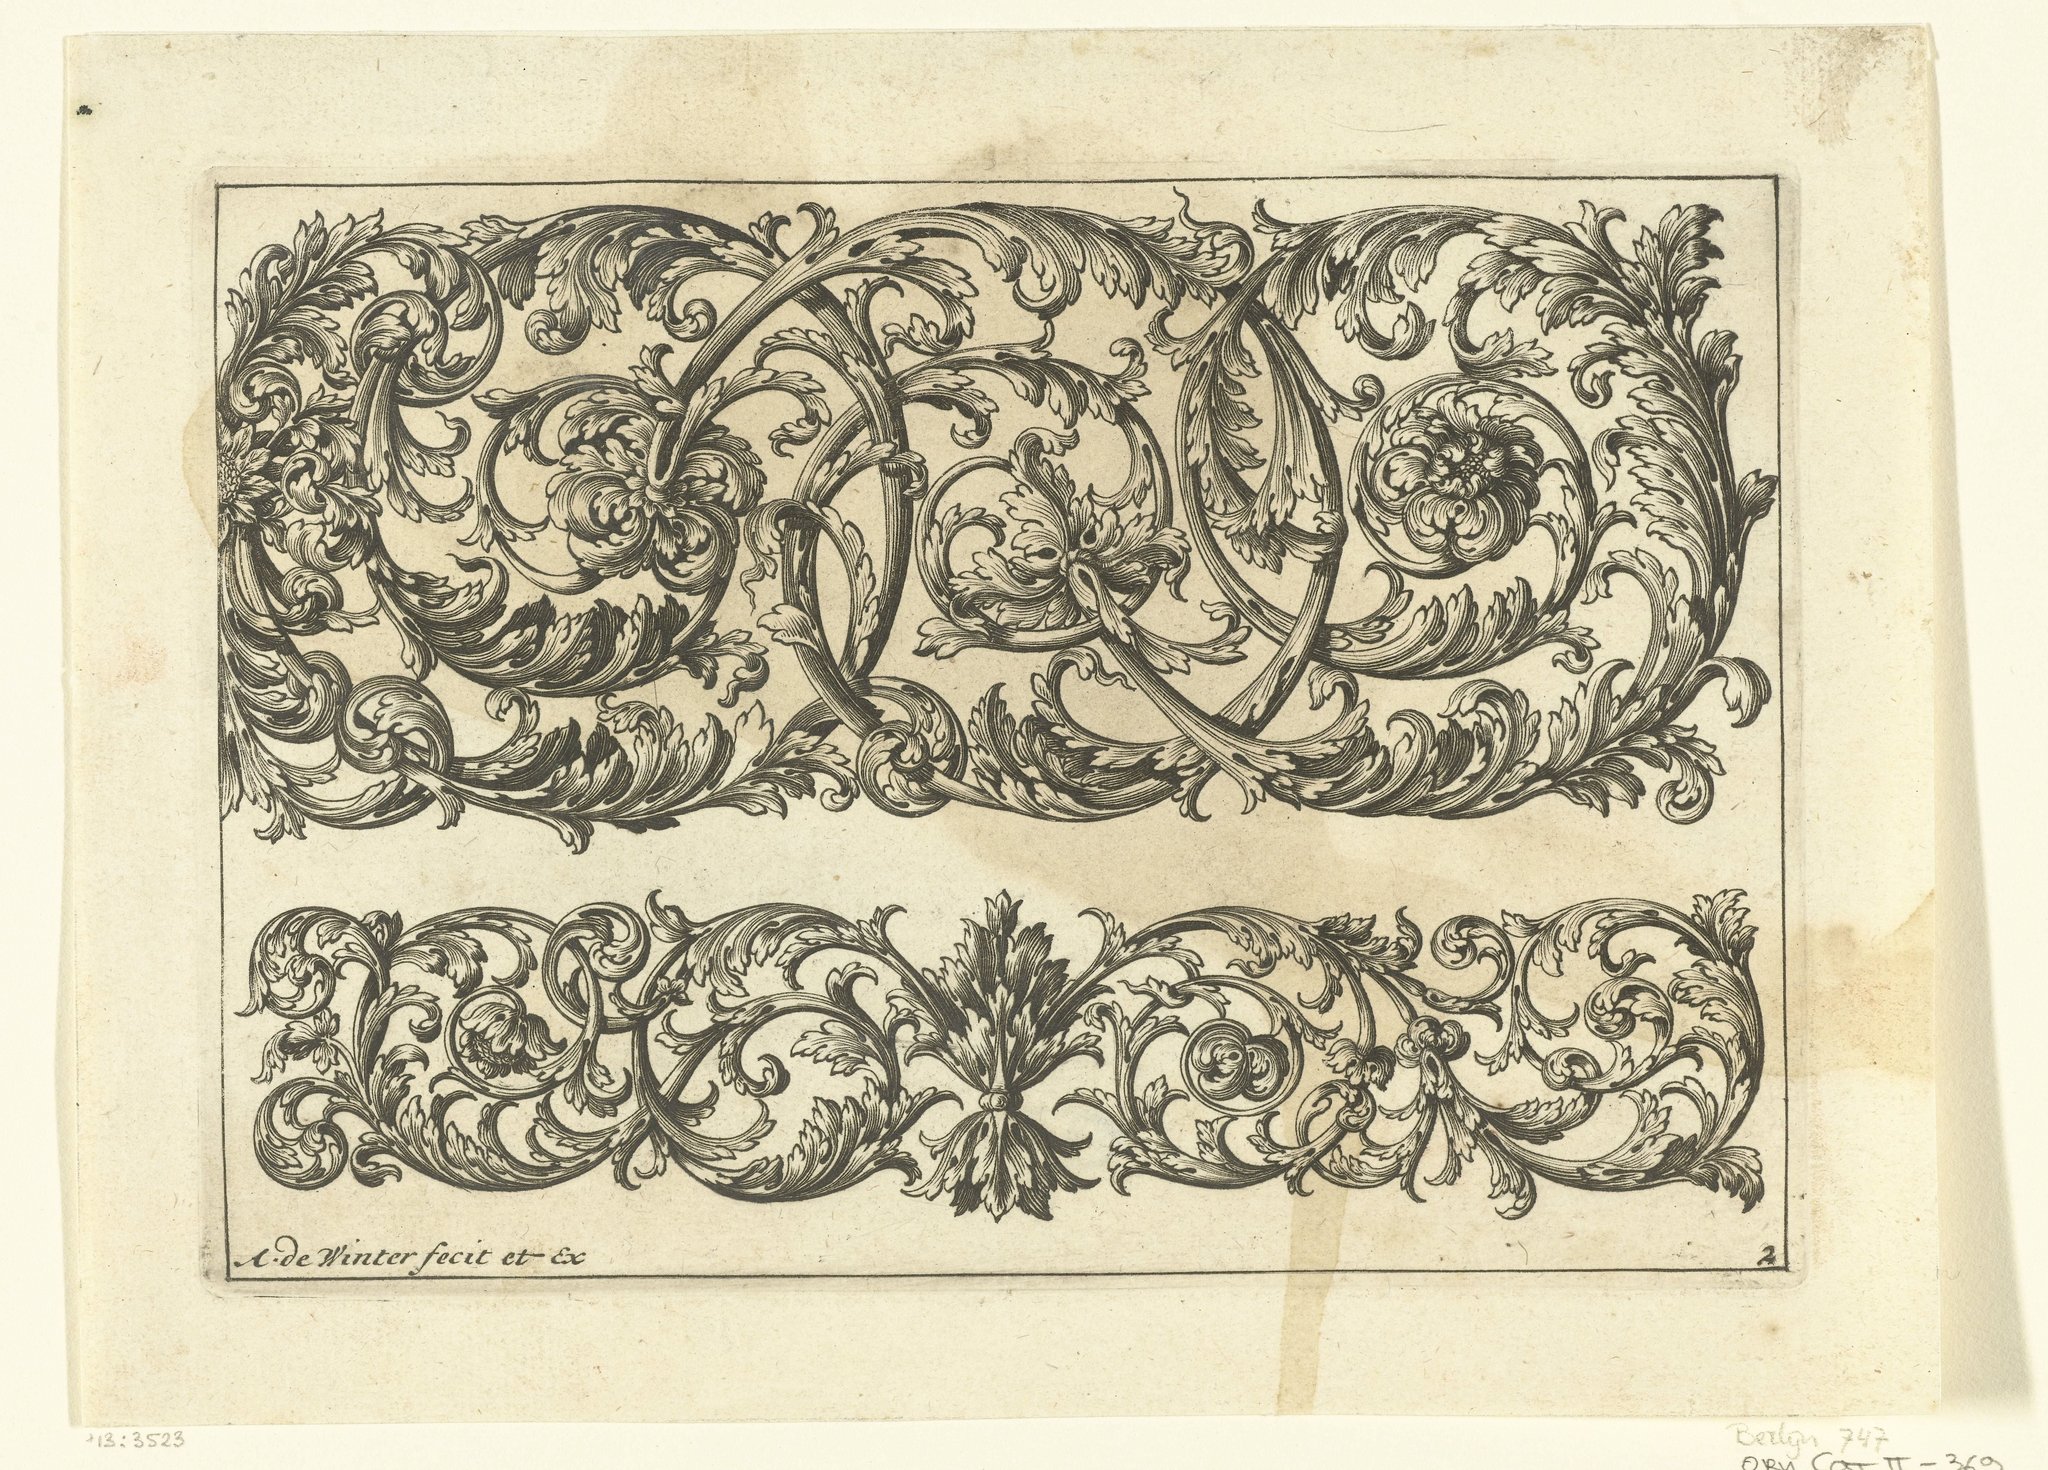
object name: ornament print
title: Twee friezen van bladranken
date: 1690-1700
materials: paper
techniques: engraving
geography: amsterdam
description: Blad uit serie met kopieën naar Stefano della Bella, Gilles Légaré, Thomas Lejuge en anderen.